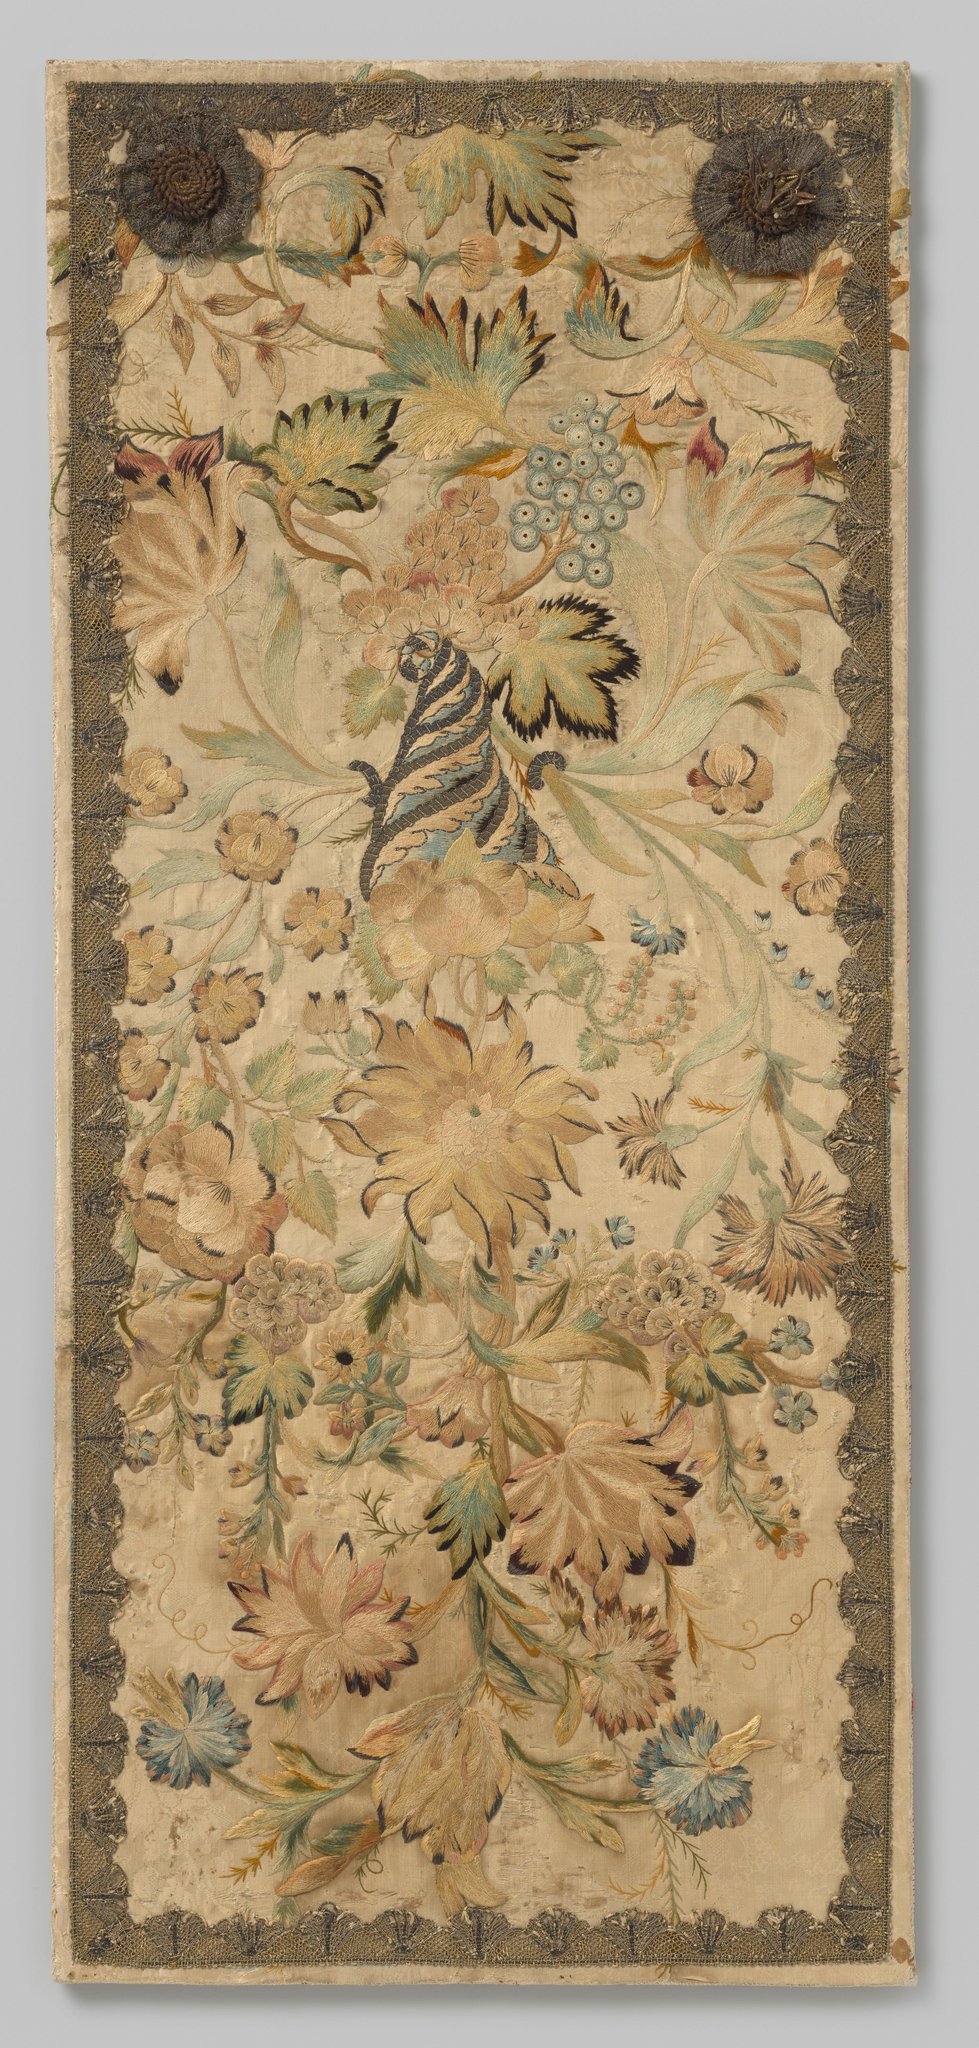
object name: fire screen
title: Vuurschermpaneel met een geborduurd bloempatroon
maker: Anonymous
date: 1730-1750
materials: silk, thread, wood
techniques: embroidered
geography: netherlands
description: Vuurschermpaneel van zijden damast waarop een borduursel van veelkleurige zijde en zilverdraad, belegd met goud- en zilverkant. Het geheel is gespannen op een houten raam. Het borduurwerk heeft een groot bloempatroon en in het benedenveld een hoornvormige schelp waaruit takken met appels en druiventrossen en bloemstengels ontspringen.